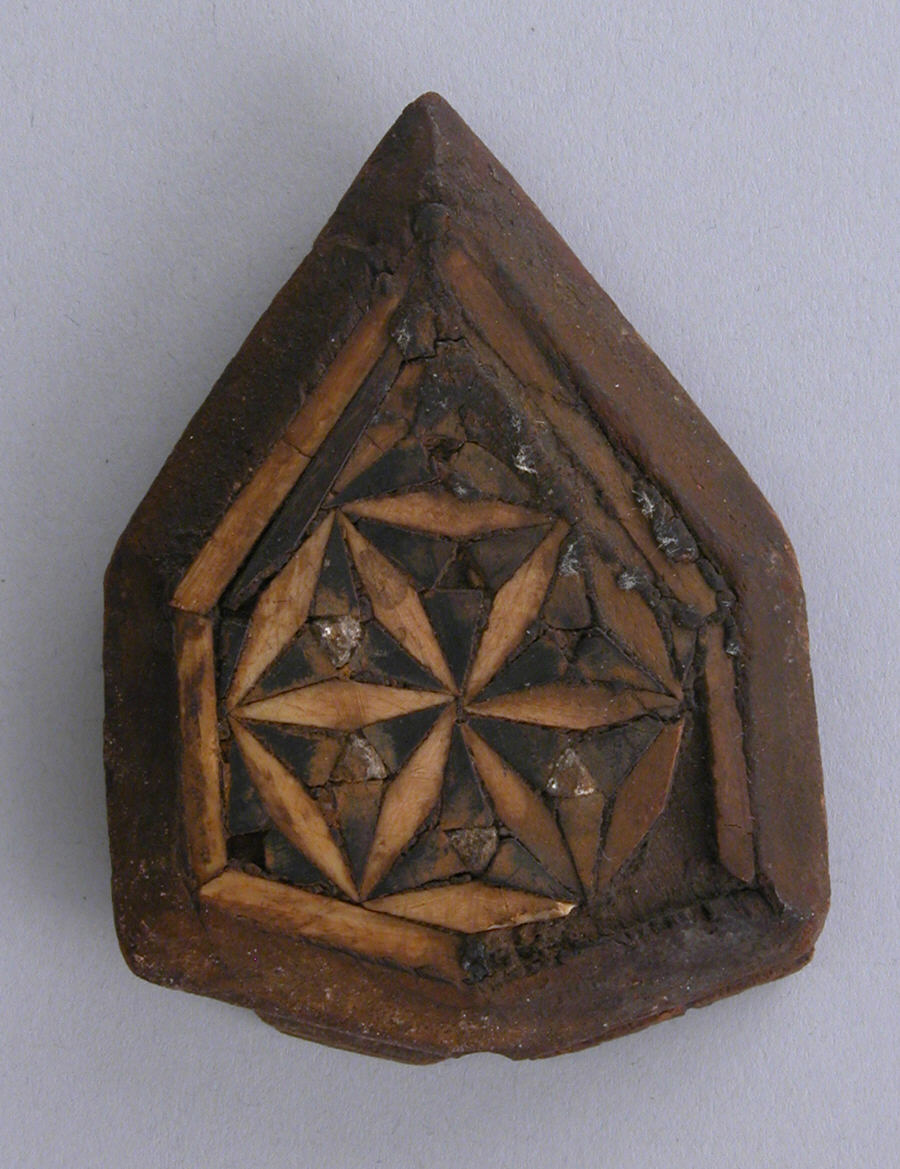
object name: panel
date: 1201-1400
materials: ivory, wood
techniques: inlay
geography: egypt